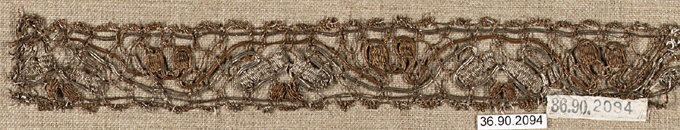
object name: piece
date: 1801-1900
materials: metal thread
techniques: lace